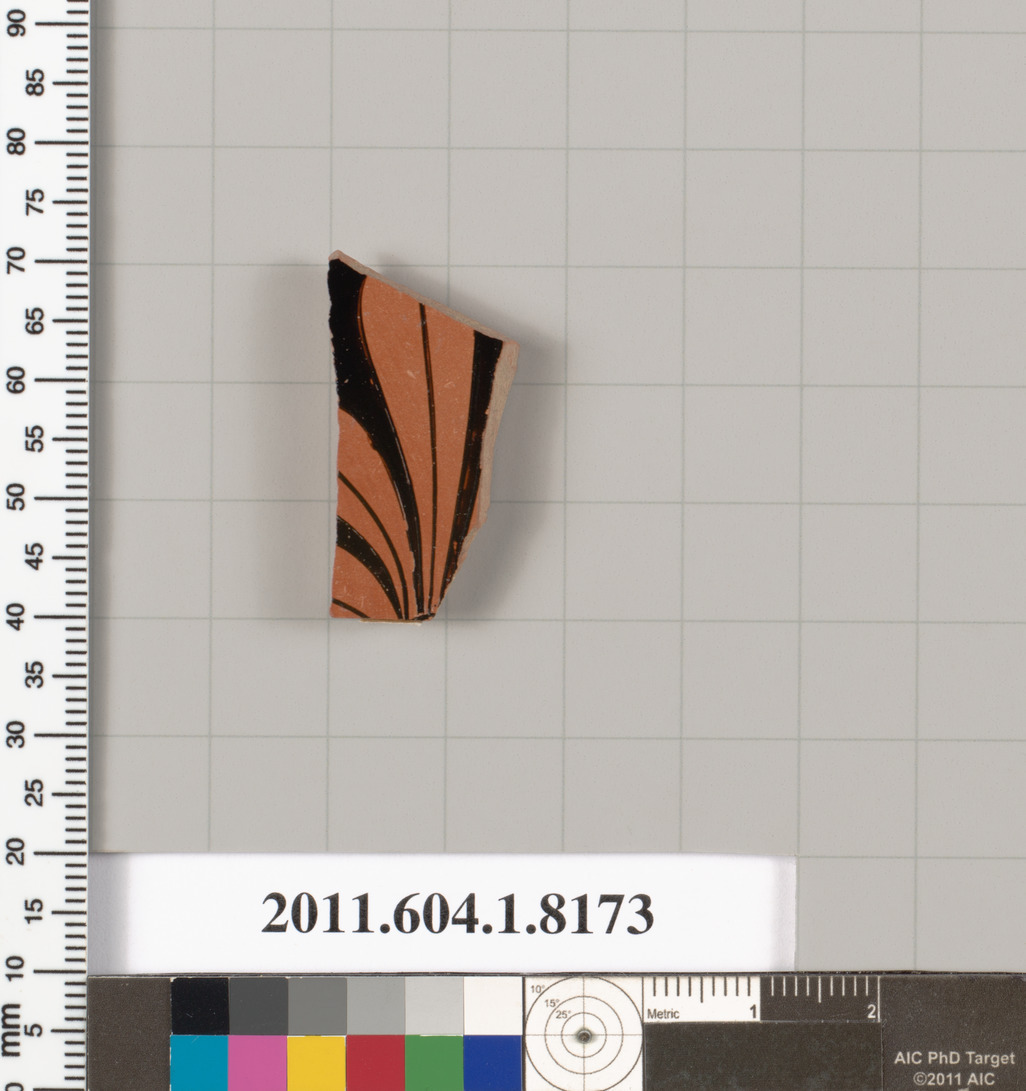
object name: kylix fragment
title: Terracotta fragment of a kylix (drinking cup)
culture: greek, attic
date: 520-510 BCE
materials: terracotta